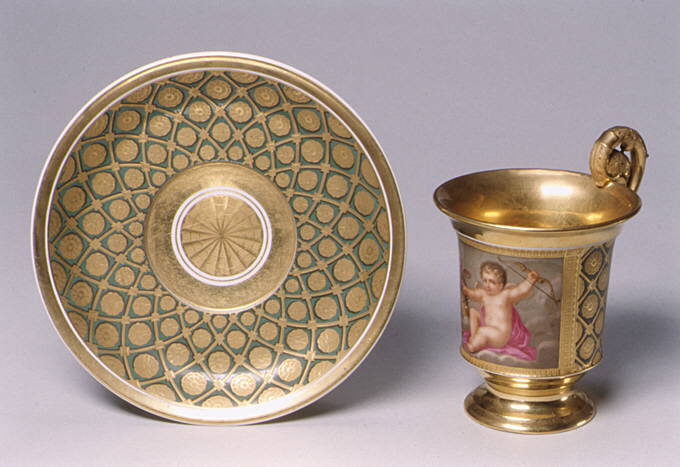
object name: cup and saucer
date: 1820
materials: hard paste porcelain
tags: cupid